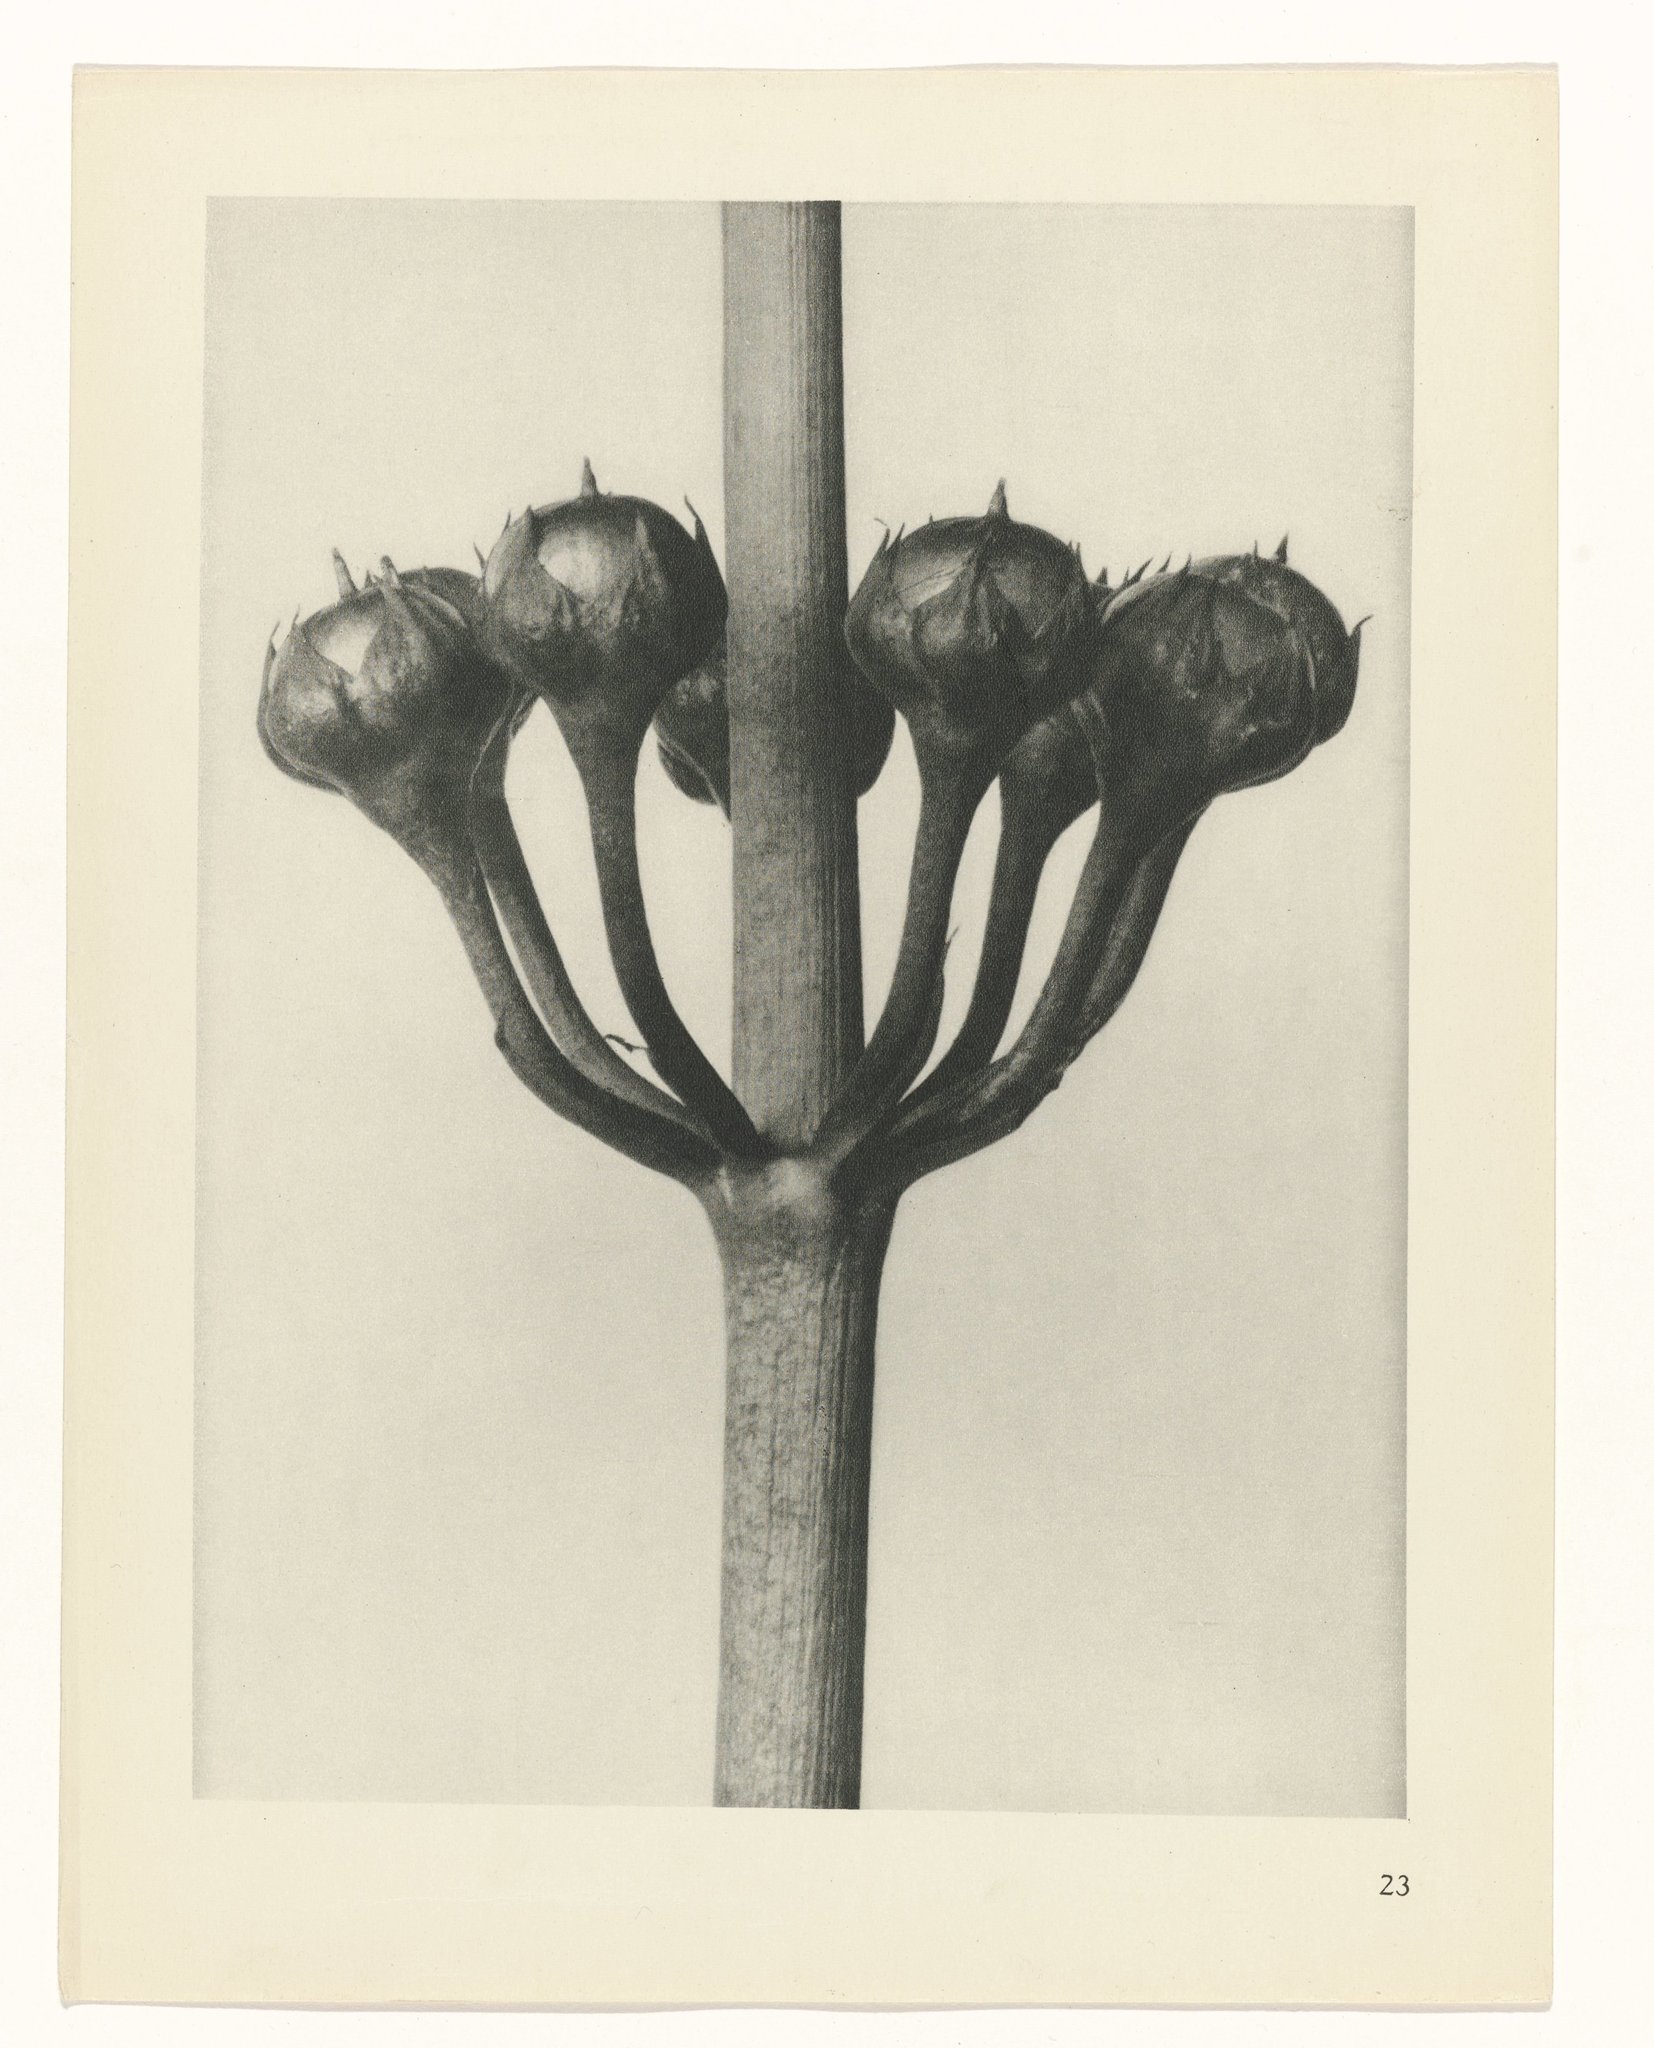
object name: photograph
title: Plantstudie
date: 1928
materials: ink, paper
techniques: rotogravure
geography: berlin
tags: plants (in general)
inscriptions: number: ‘23’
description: facher Vergrößerung. Afkomstig uit losbladige uitgave.